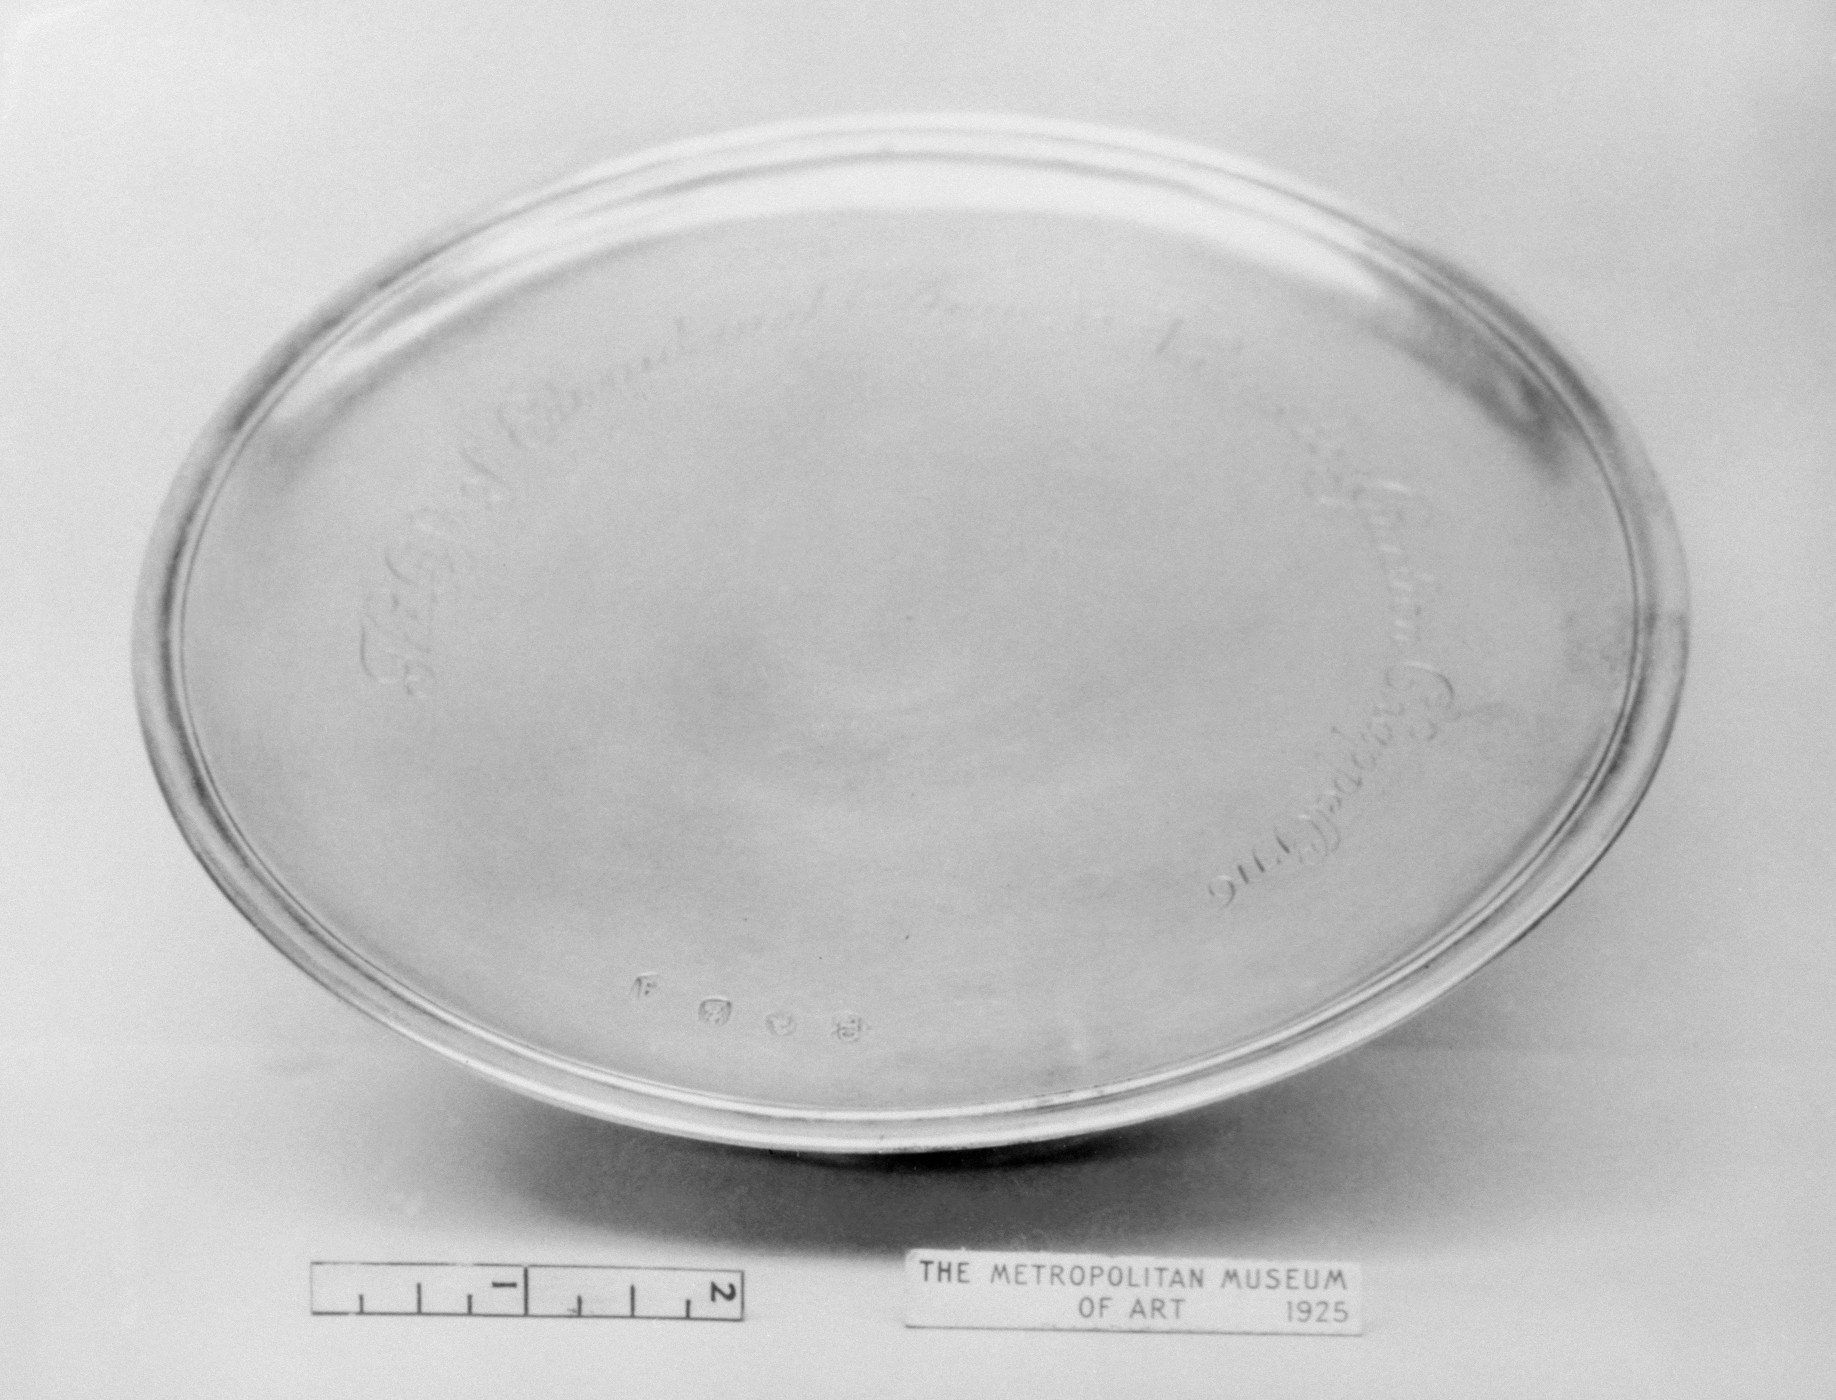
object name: paten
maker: joseph clare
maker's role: maker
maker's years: 1713-1728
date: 1716-1717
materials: silver